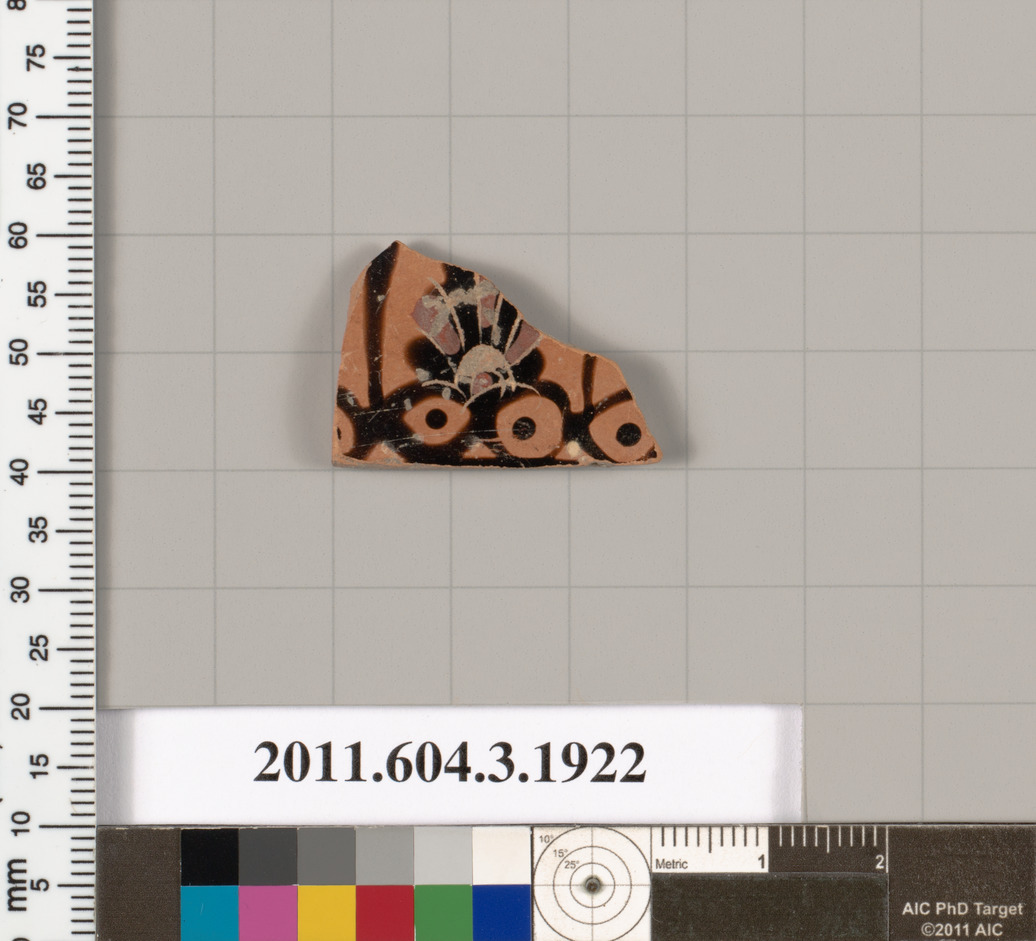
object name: kylix or skyphos fragment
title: Terracotta fragment of a kylix (drinking cup) or a skyphos (deep drinking cup)?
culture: greek, attic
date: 525-501 BCE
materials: terracotta